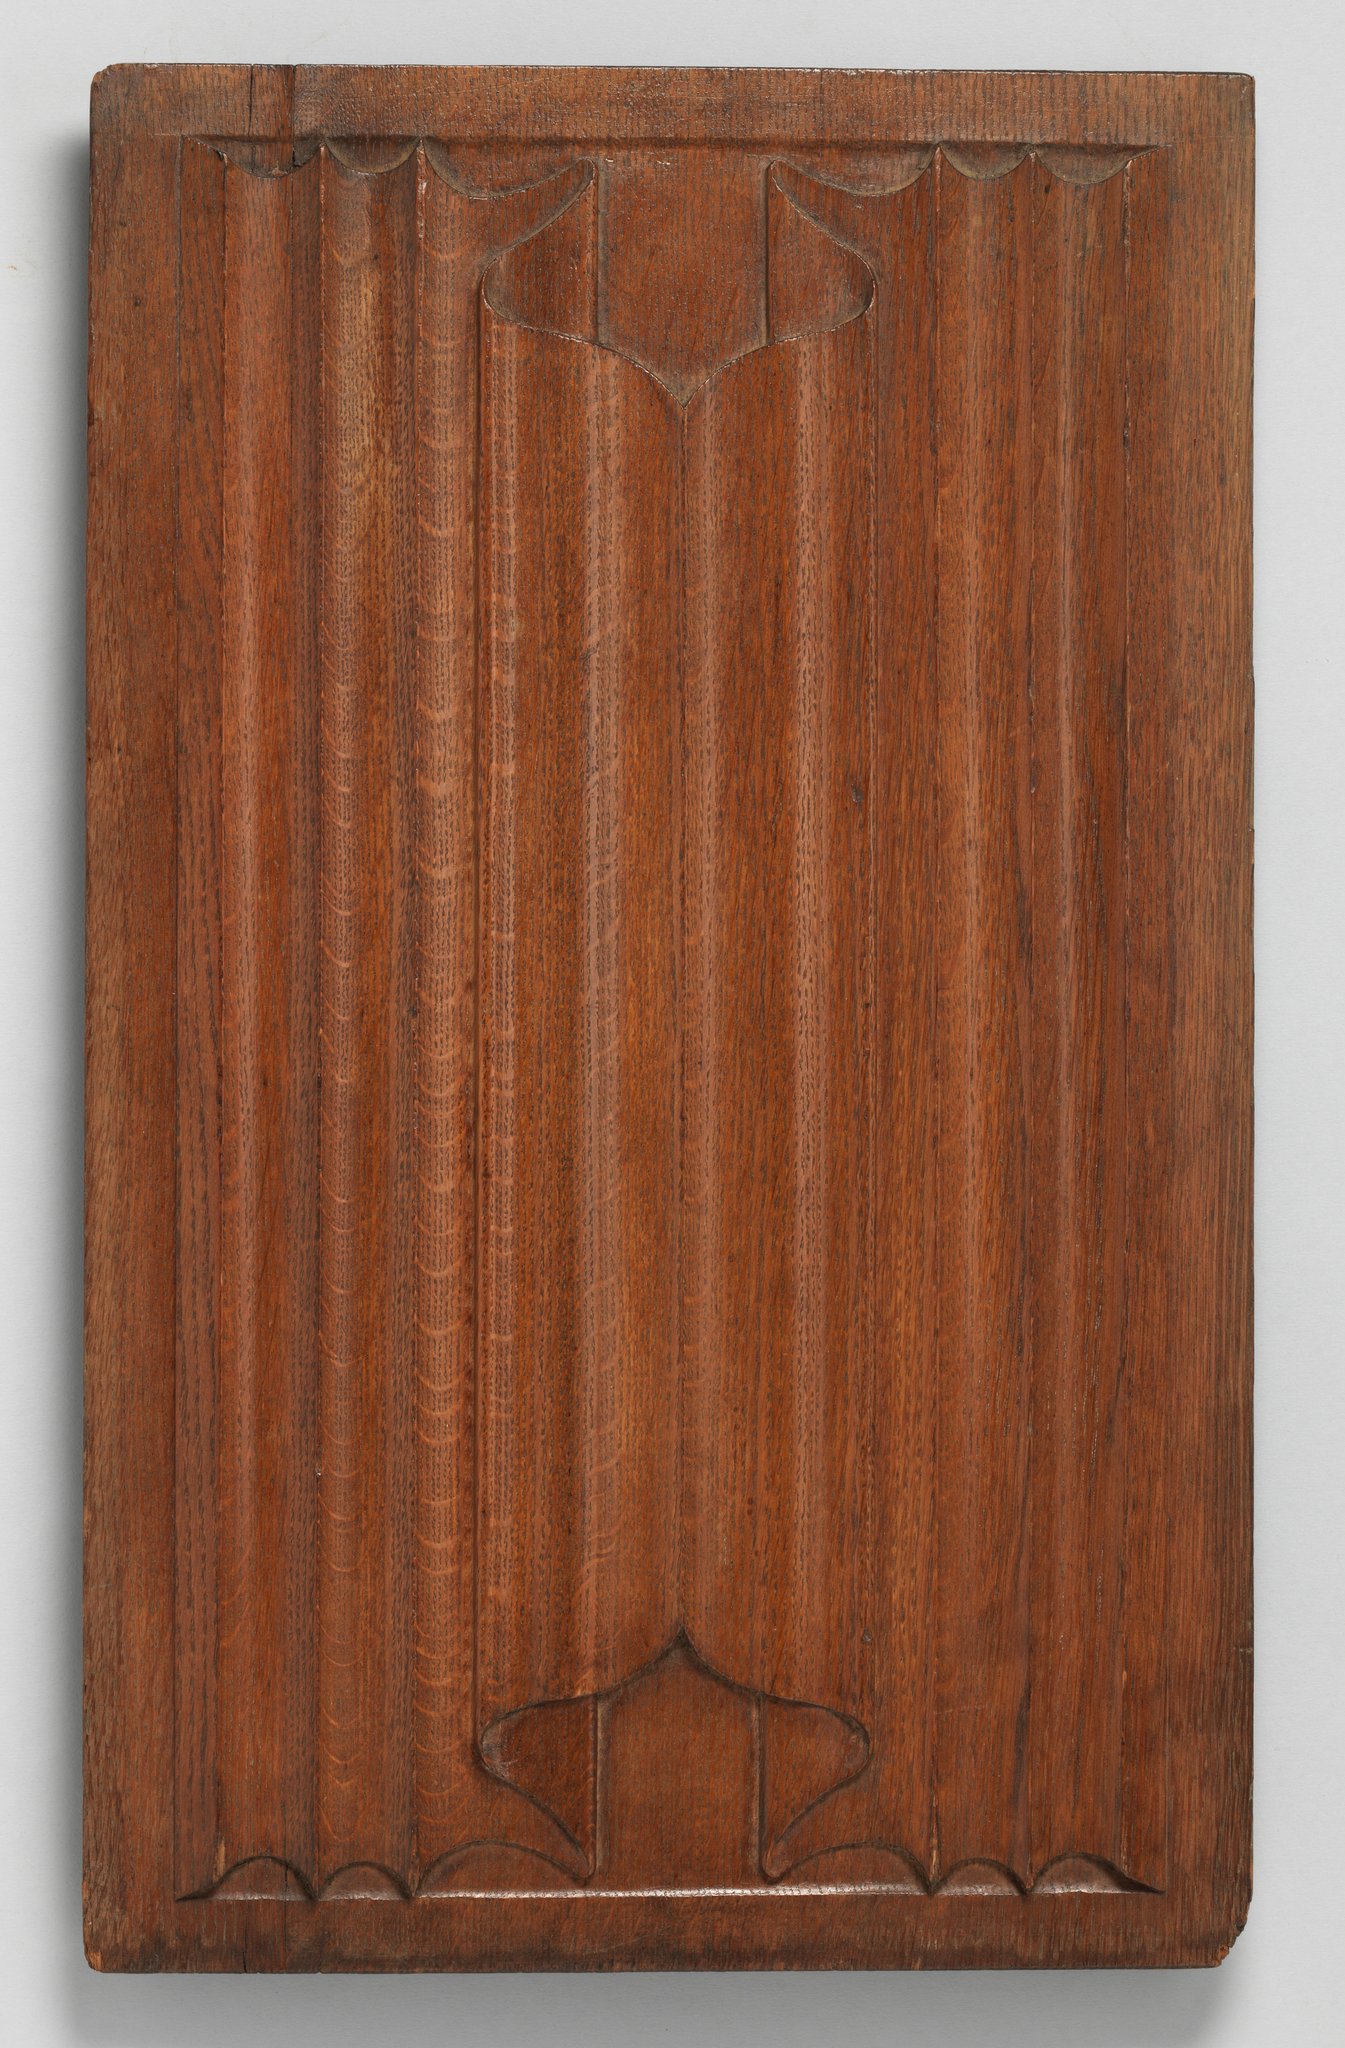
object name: panel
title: Decorative paneling from the Palace of Westminster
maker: augustus welby northmore pugin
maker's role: designer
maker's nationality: british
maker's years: 1812-1852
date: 1845-1859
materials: wood